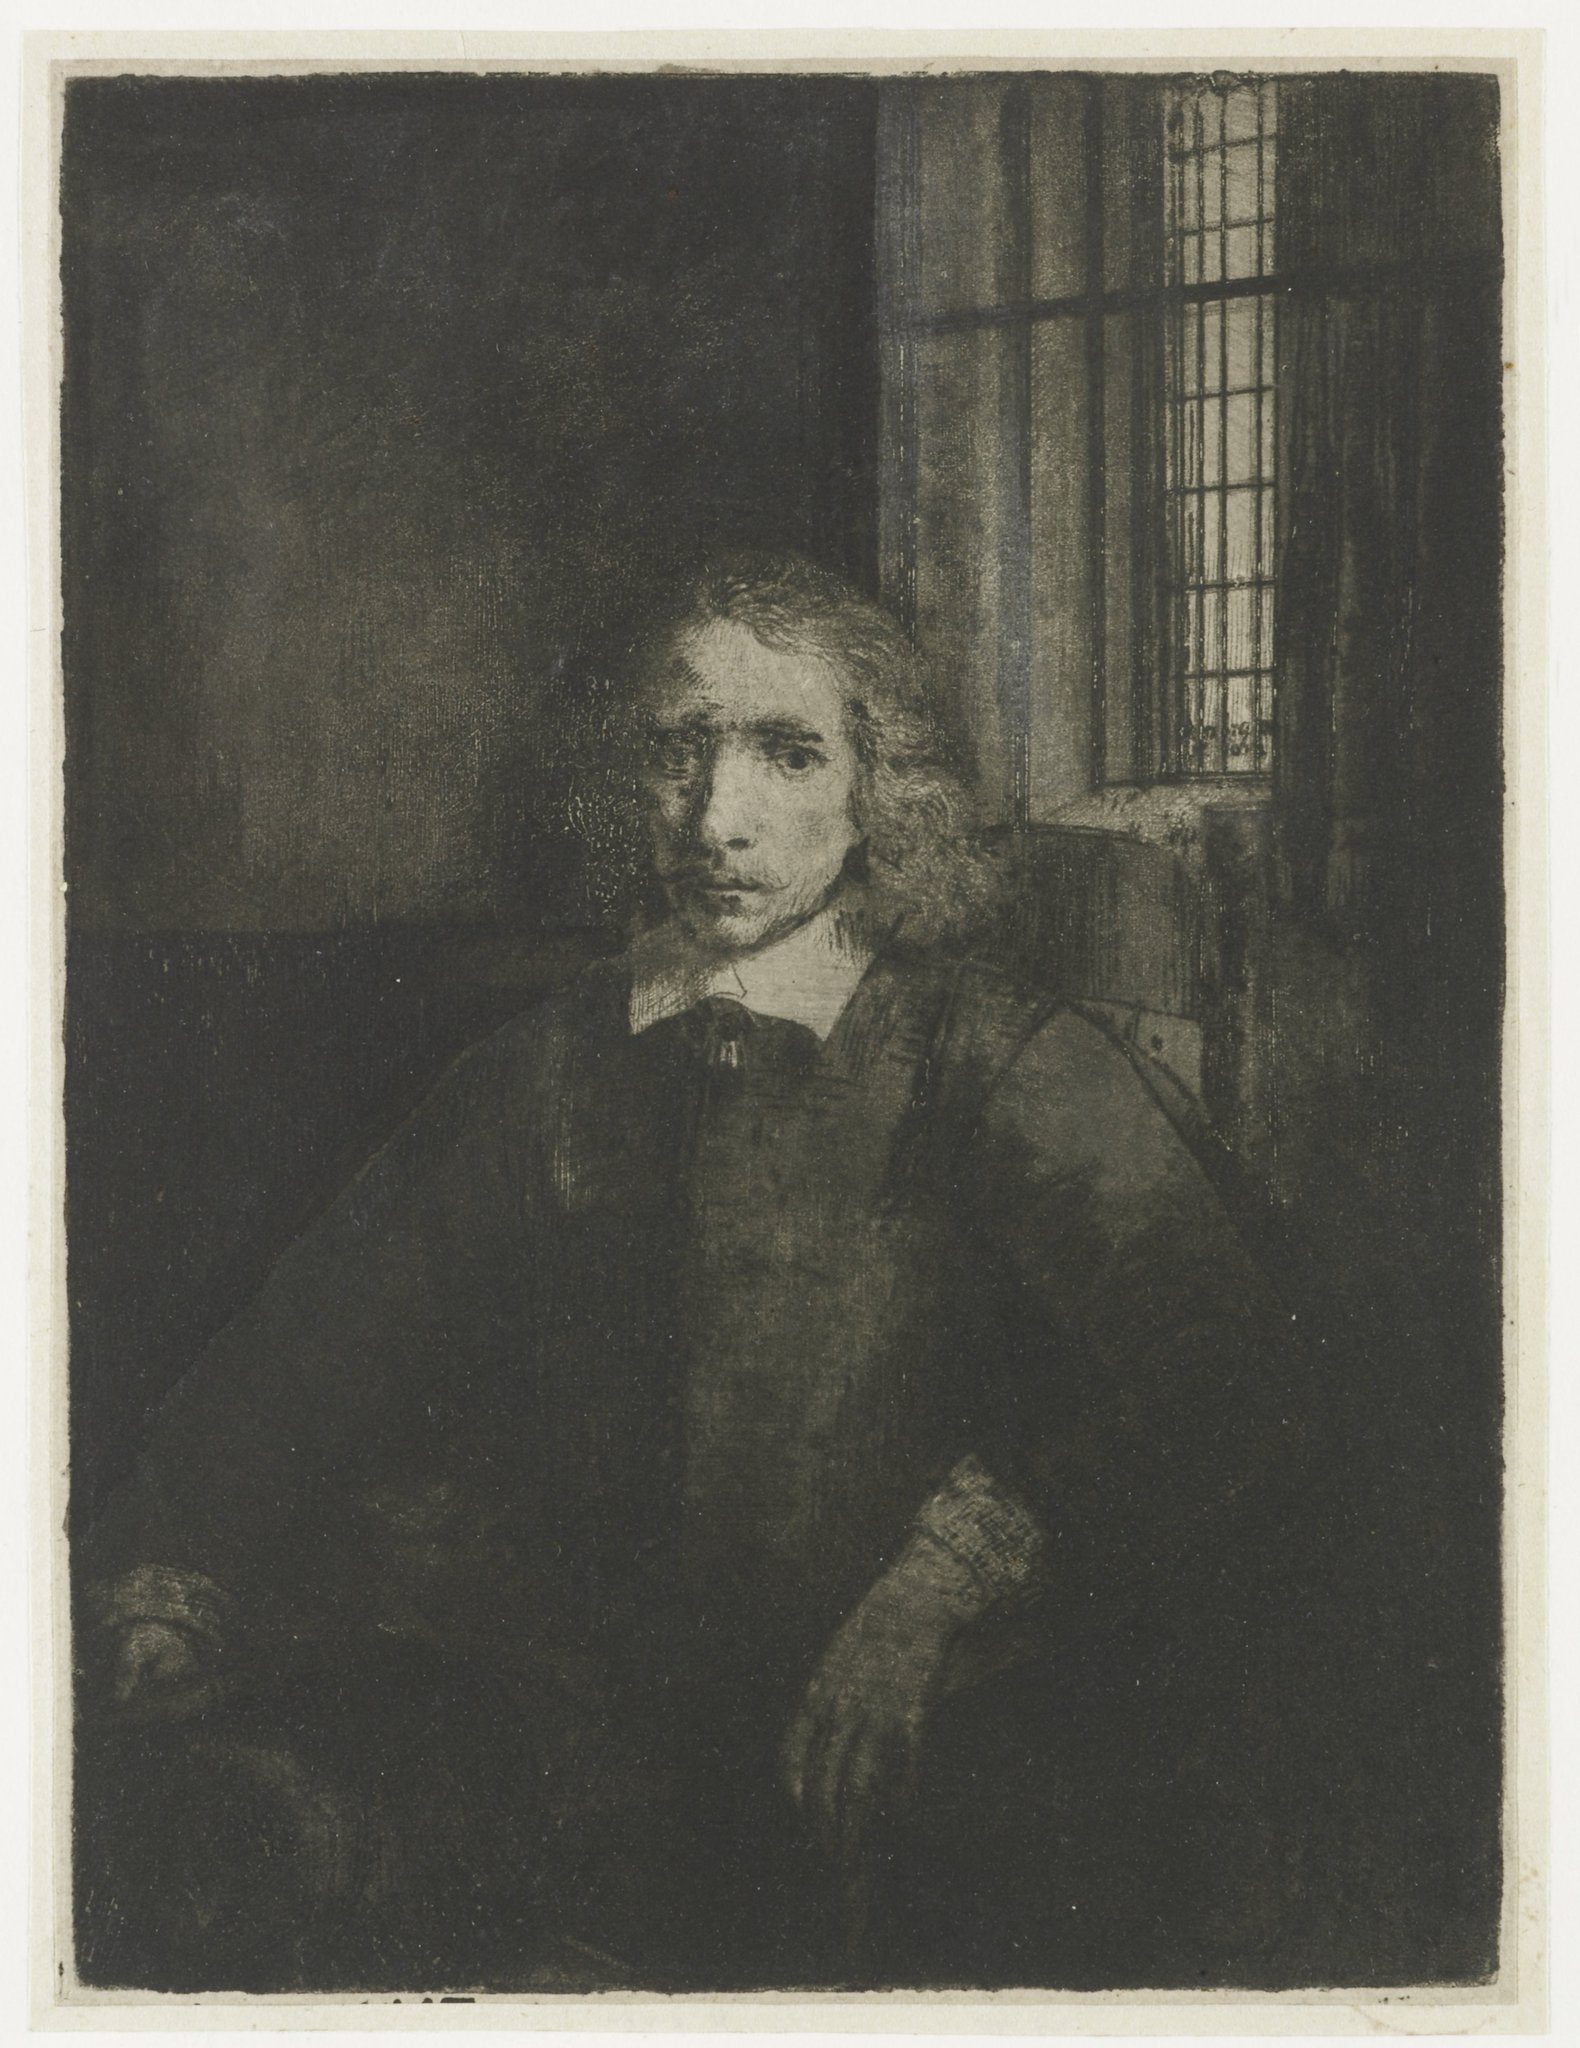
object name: print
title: Pieter Haaringh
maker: rembrandt van rijn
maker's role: draughtsman, painter, print maker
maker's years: 1606-1669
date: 1655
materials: paper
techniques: drypoint, etching, intaglio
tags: pieter haringh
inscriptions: signature and date: ‘Rembrandt f 1655’, collector's mark: Lugt 240